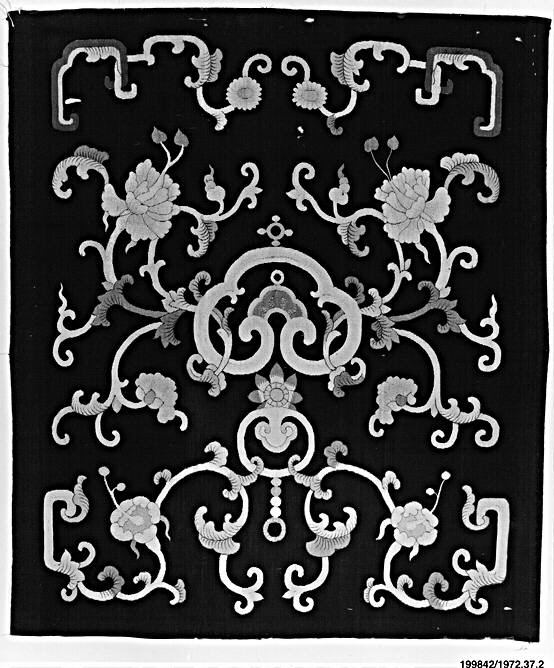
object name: panel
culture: chinese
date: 1601-1800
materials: metal thread, silk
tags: flowers